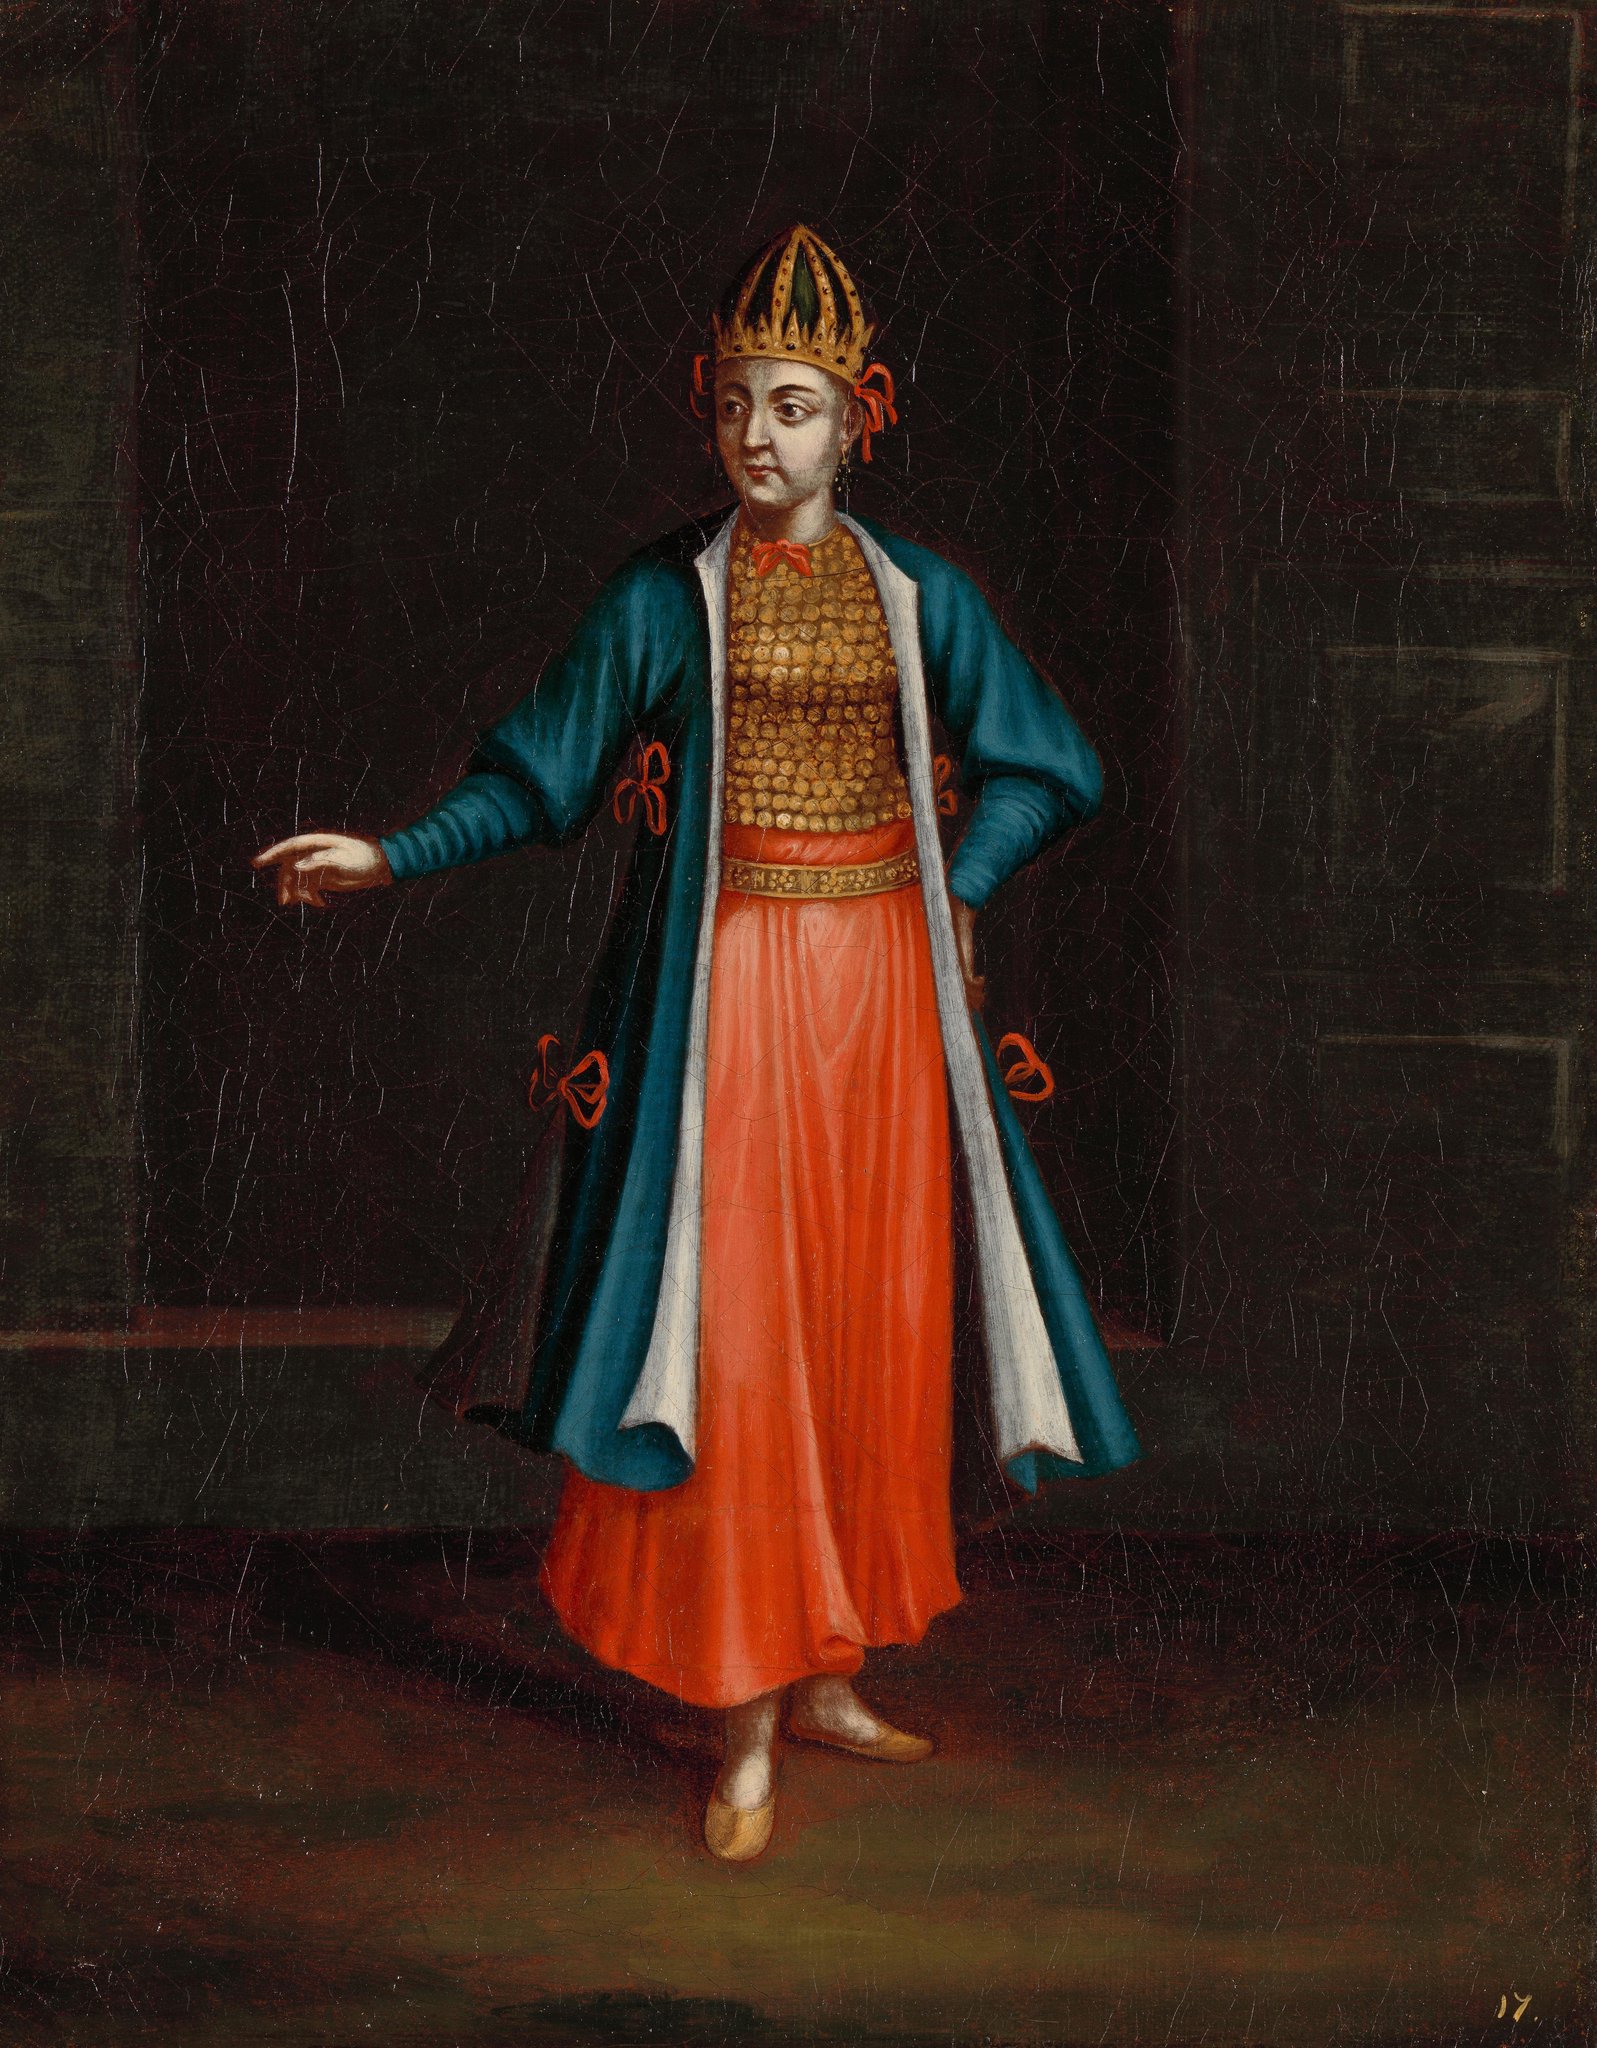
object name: painting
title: Woman from the Bulgarian Coast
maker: jean baptiste vanmour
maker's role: painter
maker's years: 1671-1737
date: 1700-1737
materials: canvas, oil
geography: istanbul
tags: standing figure, folk costume, regional costume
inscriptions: inscription: ‘Femme de Boulgar, Vanm. / Een vrouw van de kust Bolgardo’, number: ‘17’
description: Een Bulgaarse vrouw, staande, ten voeten uit, met uitgestoken rechterhand.